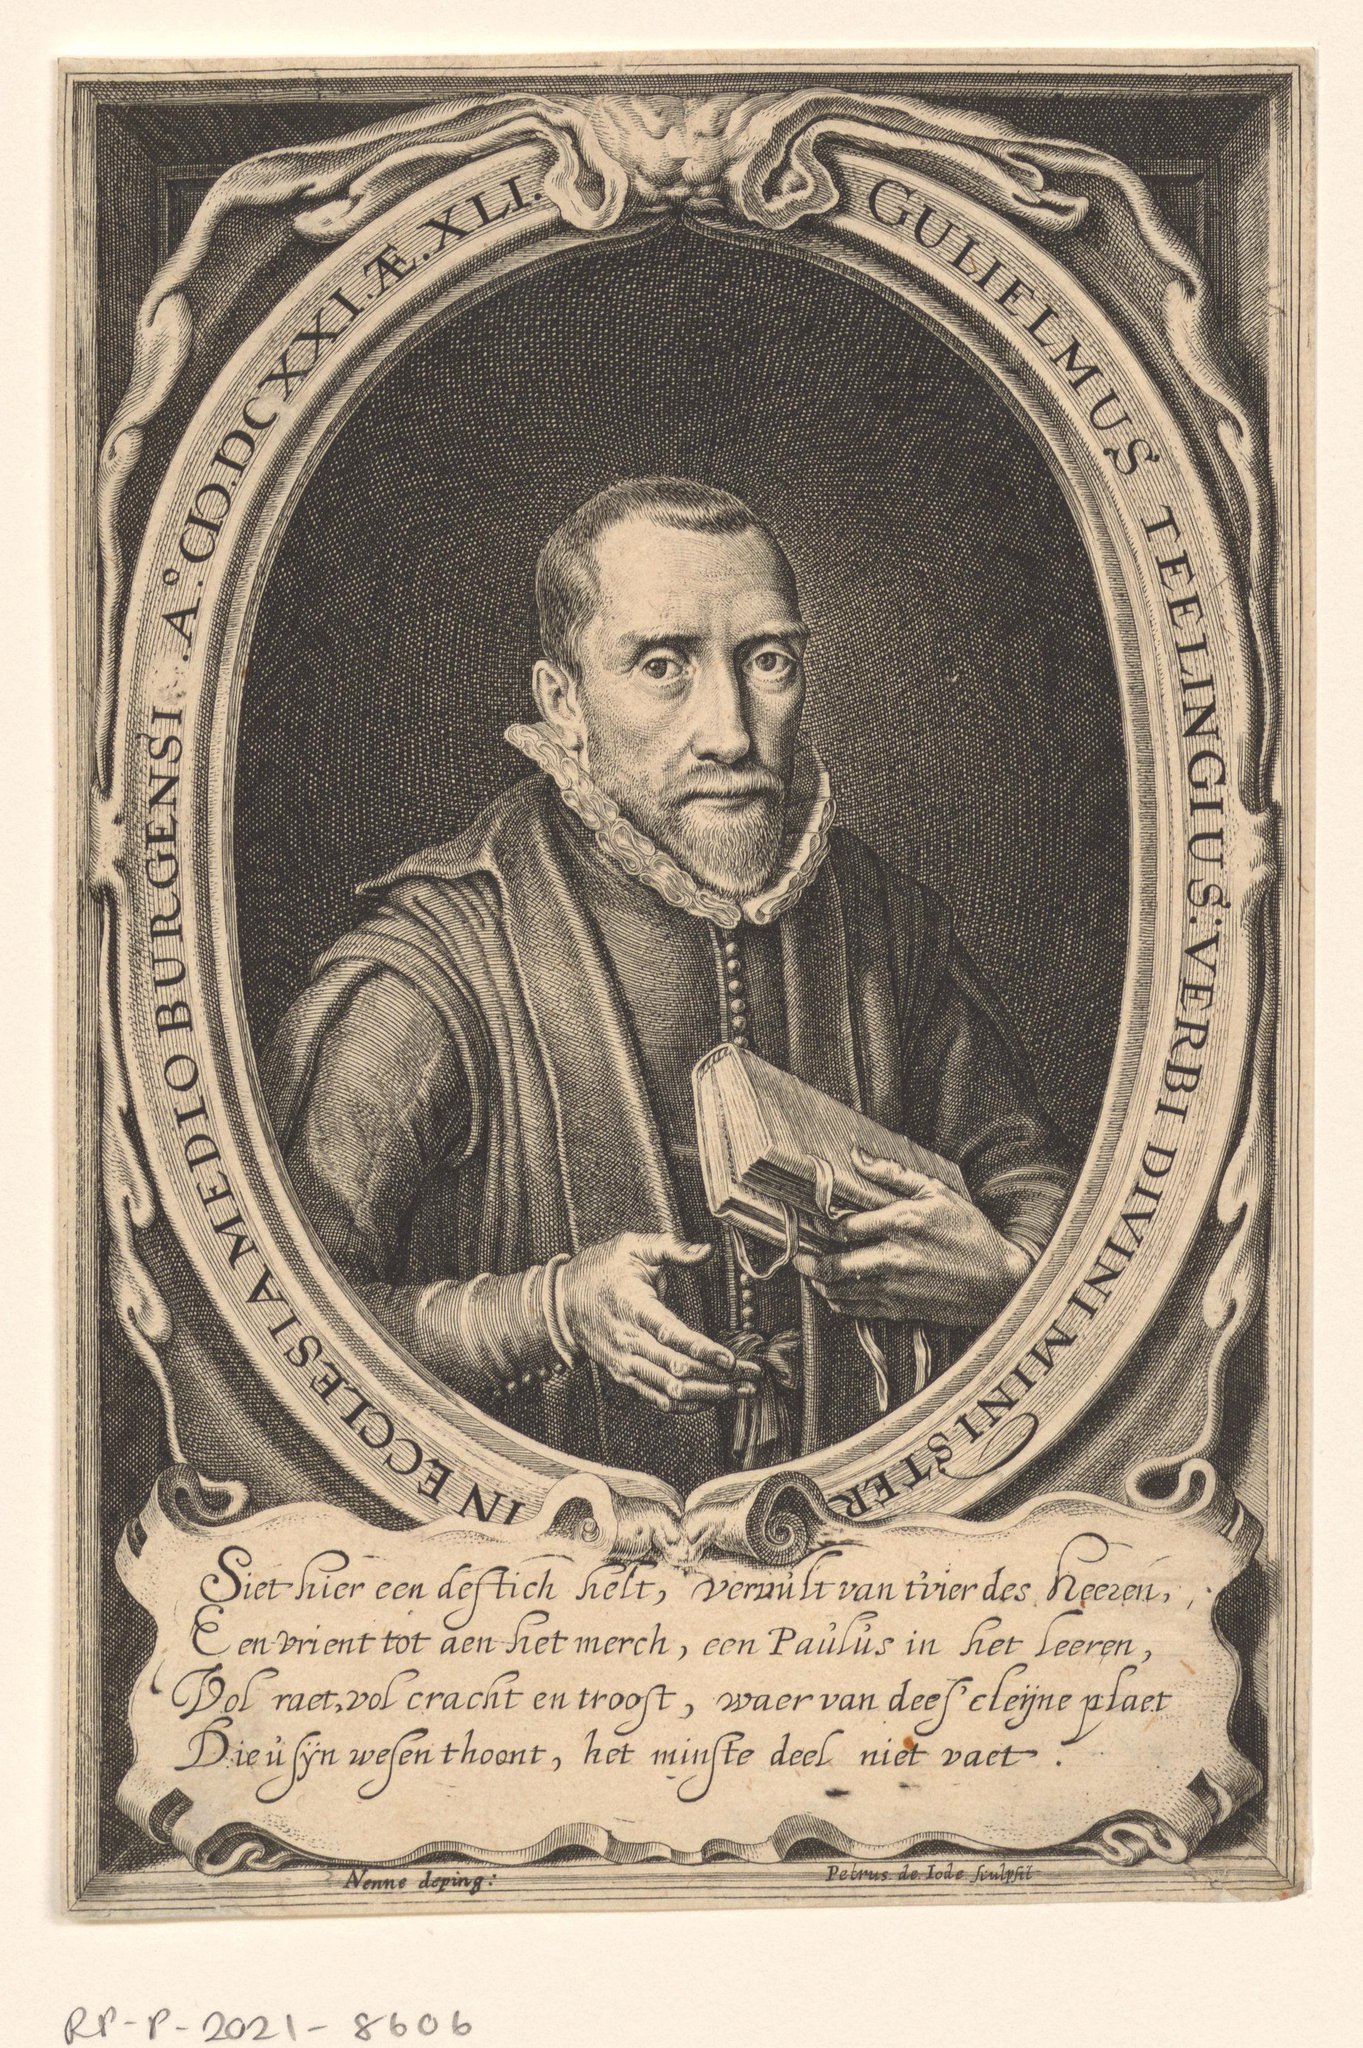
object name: print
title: Portret van Willem Teellinck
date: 1590-1632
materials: paper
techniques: engraving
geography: antwerp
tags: middelburg, theologian, historical persons, functionaries and dignitaries ~ episcopal protestant churches, book